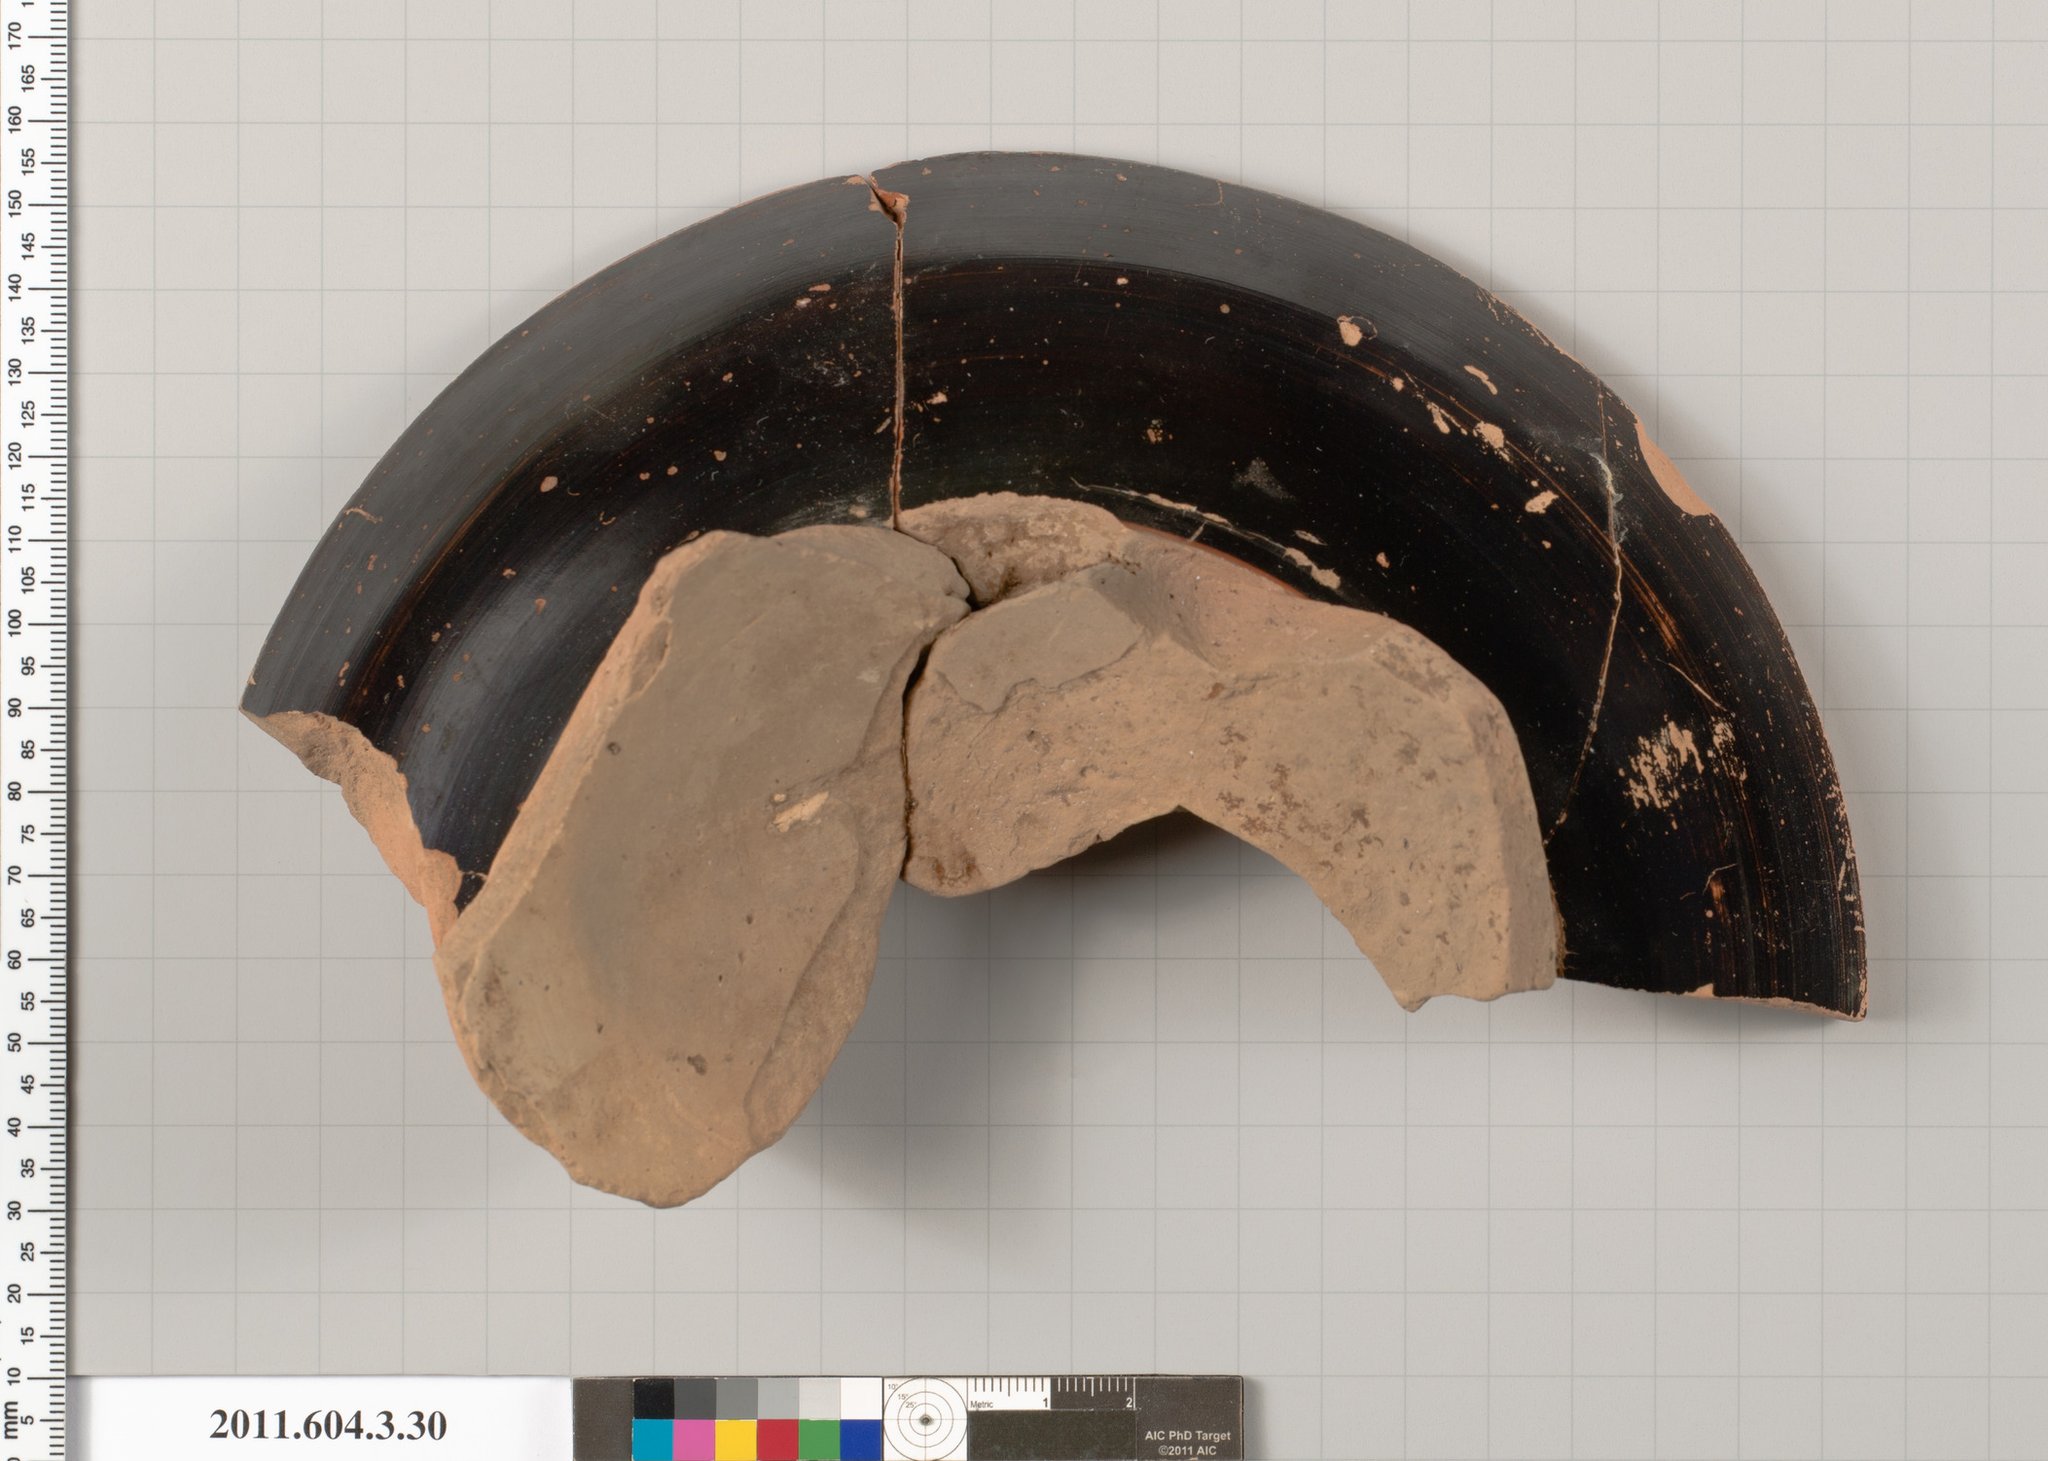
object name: amphora fragment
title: Terracotta fragment of an amphora (jar)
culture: greek, attic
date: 600-401 BCE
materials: terracotta